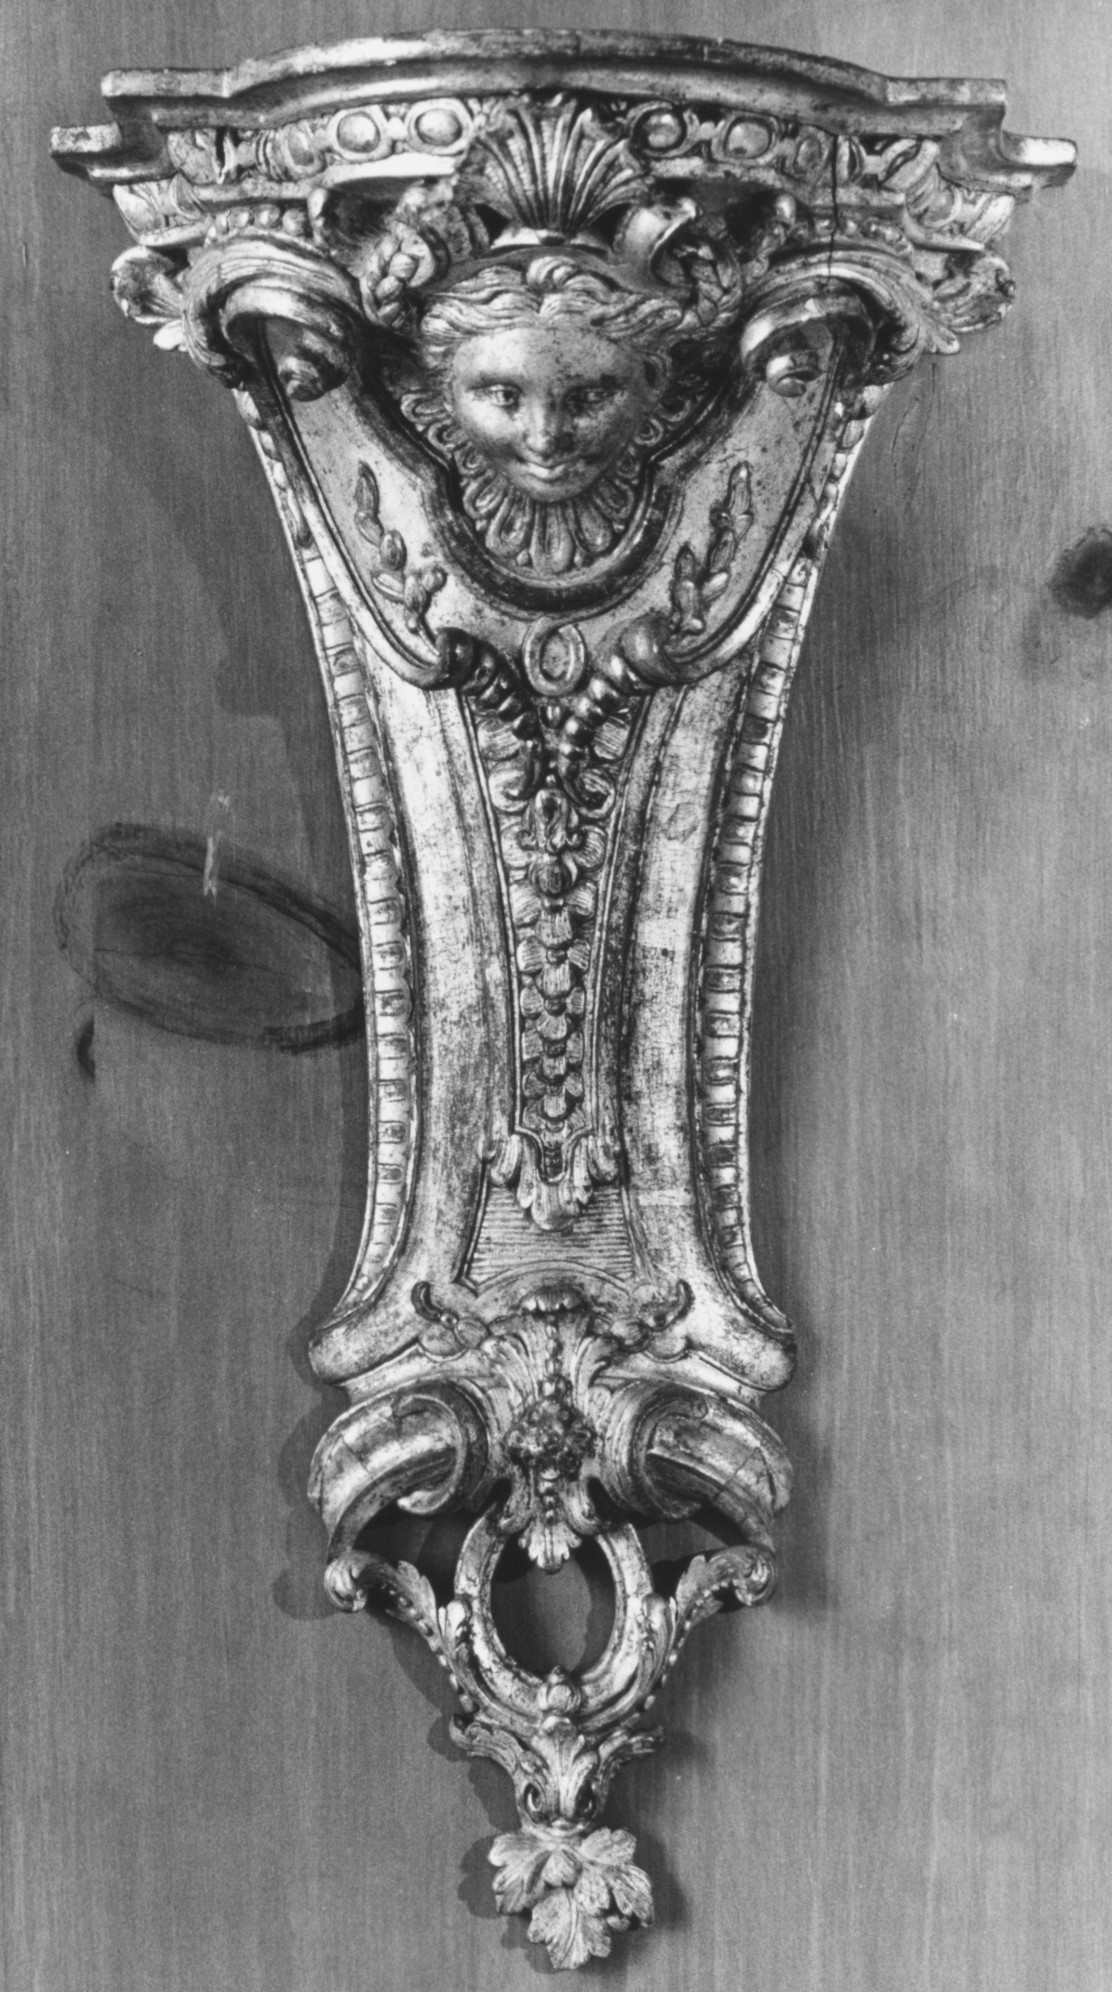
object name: wall bracket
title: Pair of wall brackets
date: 1725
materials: wood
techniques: carving, gilding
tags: faces